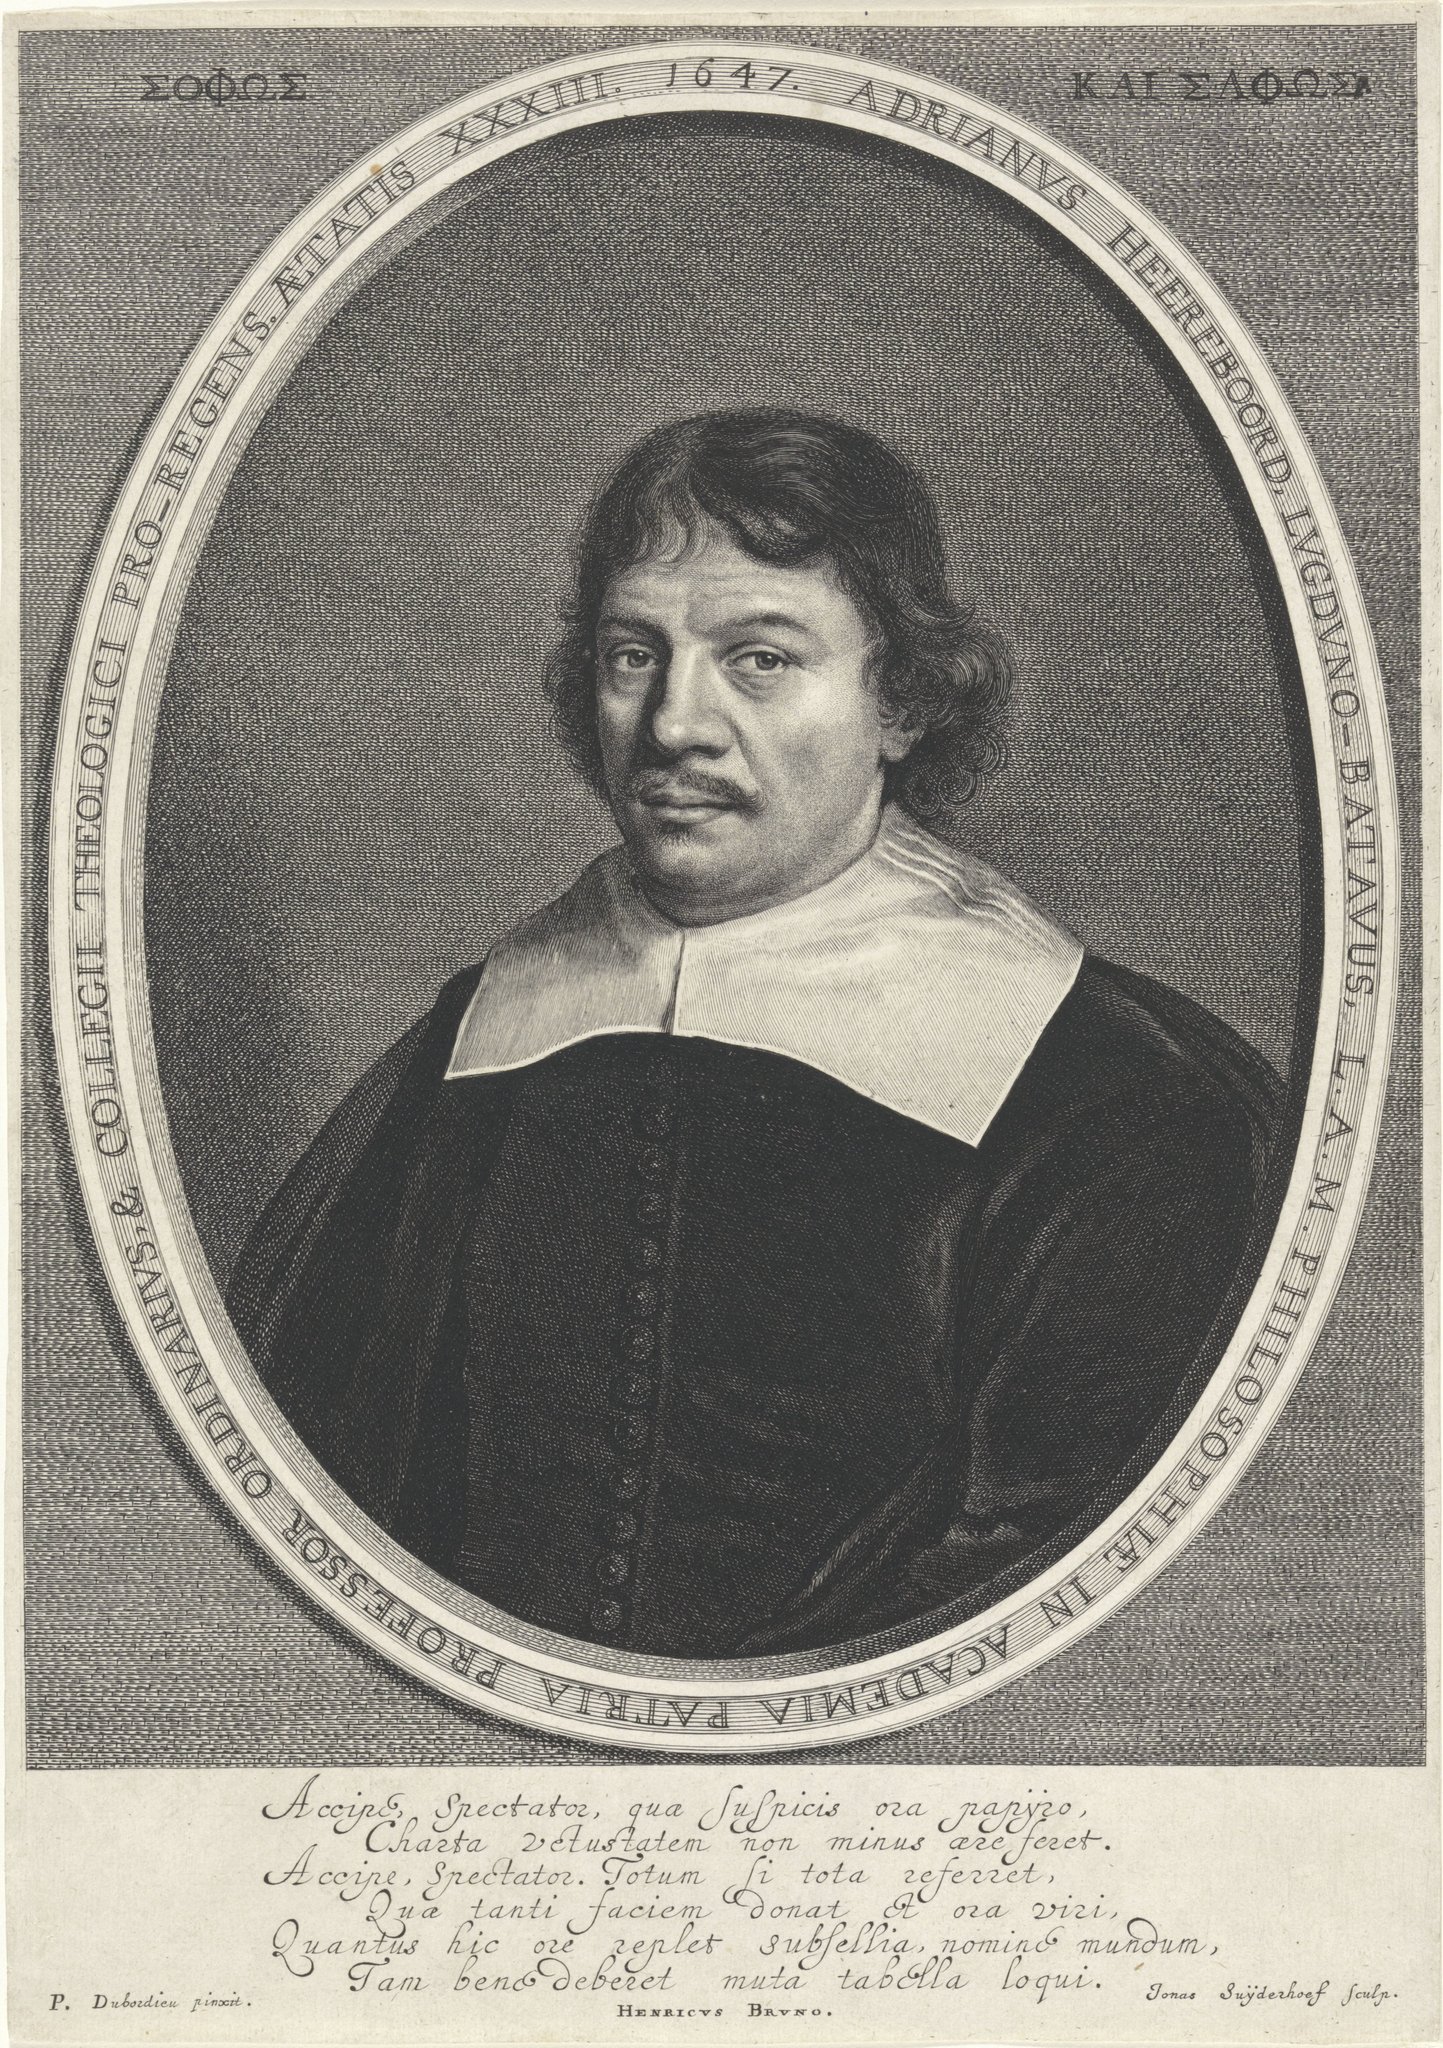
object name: print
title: Portret van Adriaan Heereboord in ovaal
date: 1647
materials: paper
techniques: engraving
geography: haarlem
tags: professor (+ portrait of teacher, professor)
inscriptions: collector's mark: Lugt 240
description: Portret van Adriaan Heereboord, hoogleraar redeneerkunde en wijsbegeerte aan de universiteit van Leiden, op 33-jarige leeftijd. Onderaan in de marge een zesregelig vers in het Latijn.